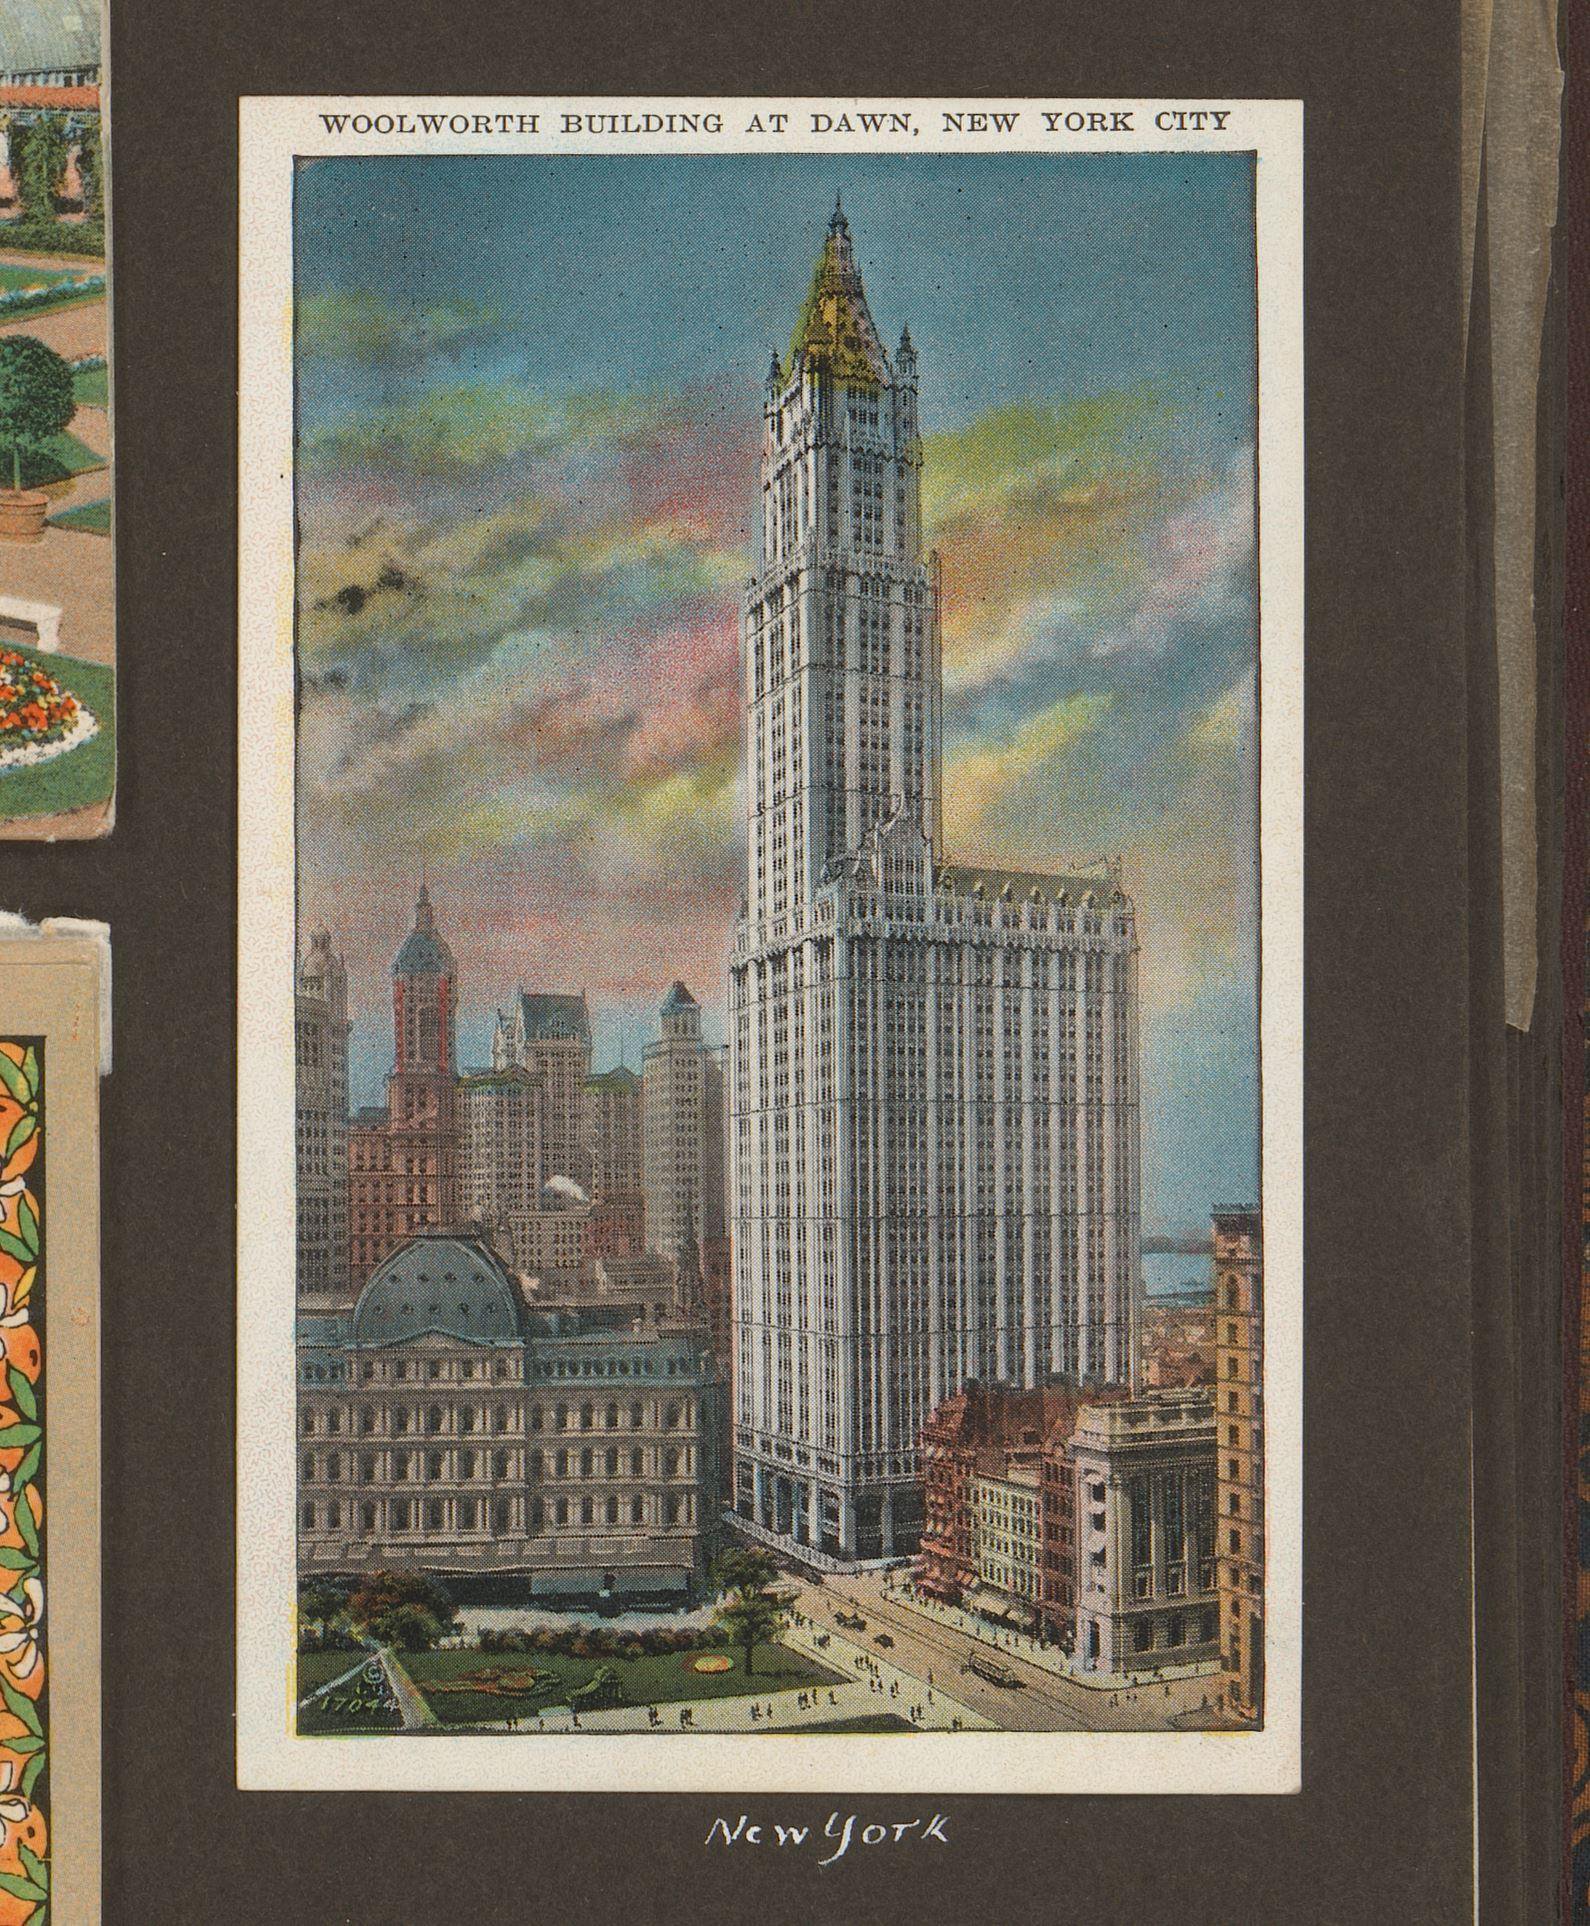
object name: album leaf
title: Woolworth building at dawn, New York City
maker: Anonymous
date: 1928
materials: paper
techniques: four-color autotype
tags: skyscraper, new york (city)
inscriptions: number: ‘17044’, annotation: ‘New York’